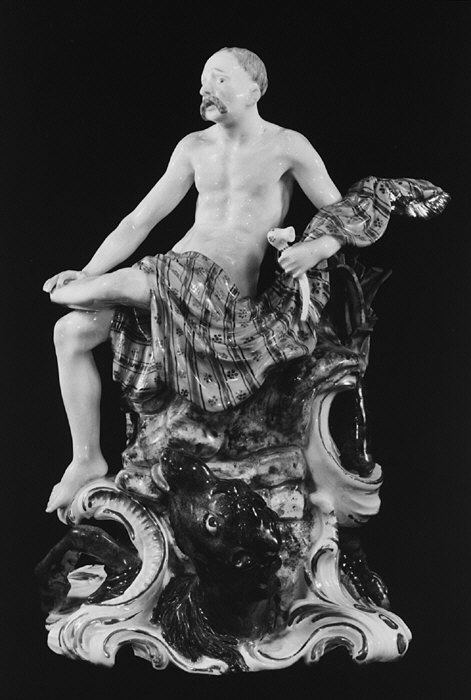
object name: figure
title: Asia (part of a set)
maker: nymphenburg porcelain manufactory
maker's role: manufactory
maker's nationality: german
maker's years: 1747-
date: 1763-1767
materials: hard paste porcelain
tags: men